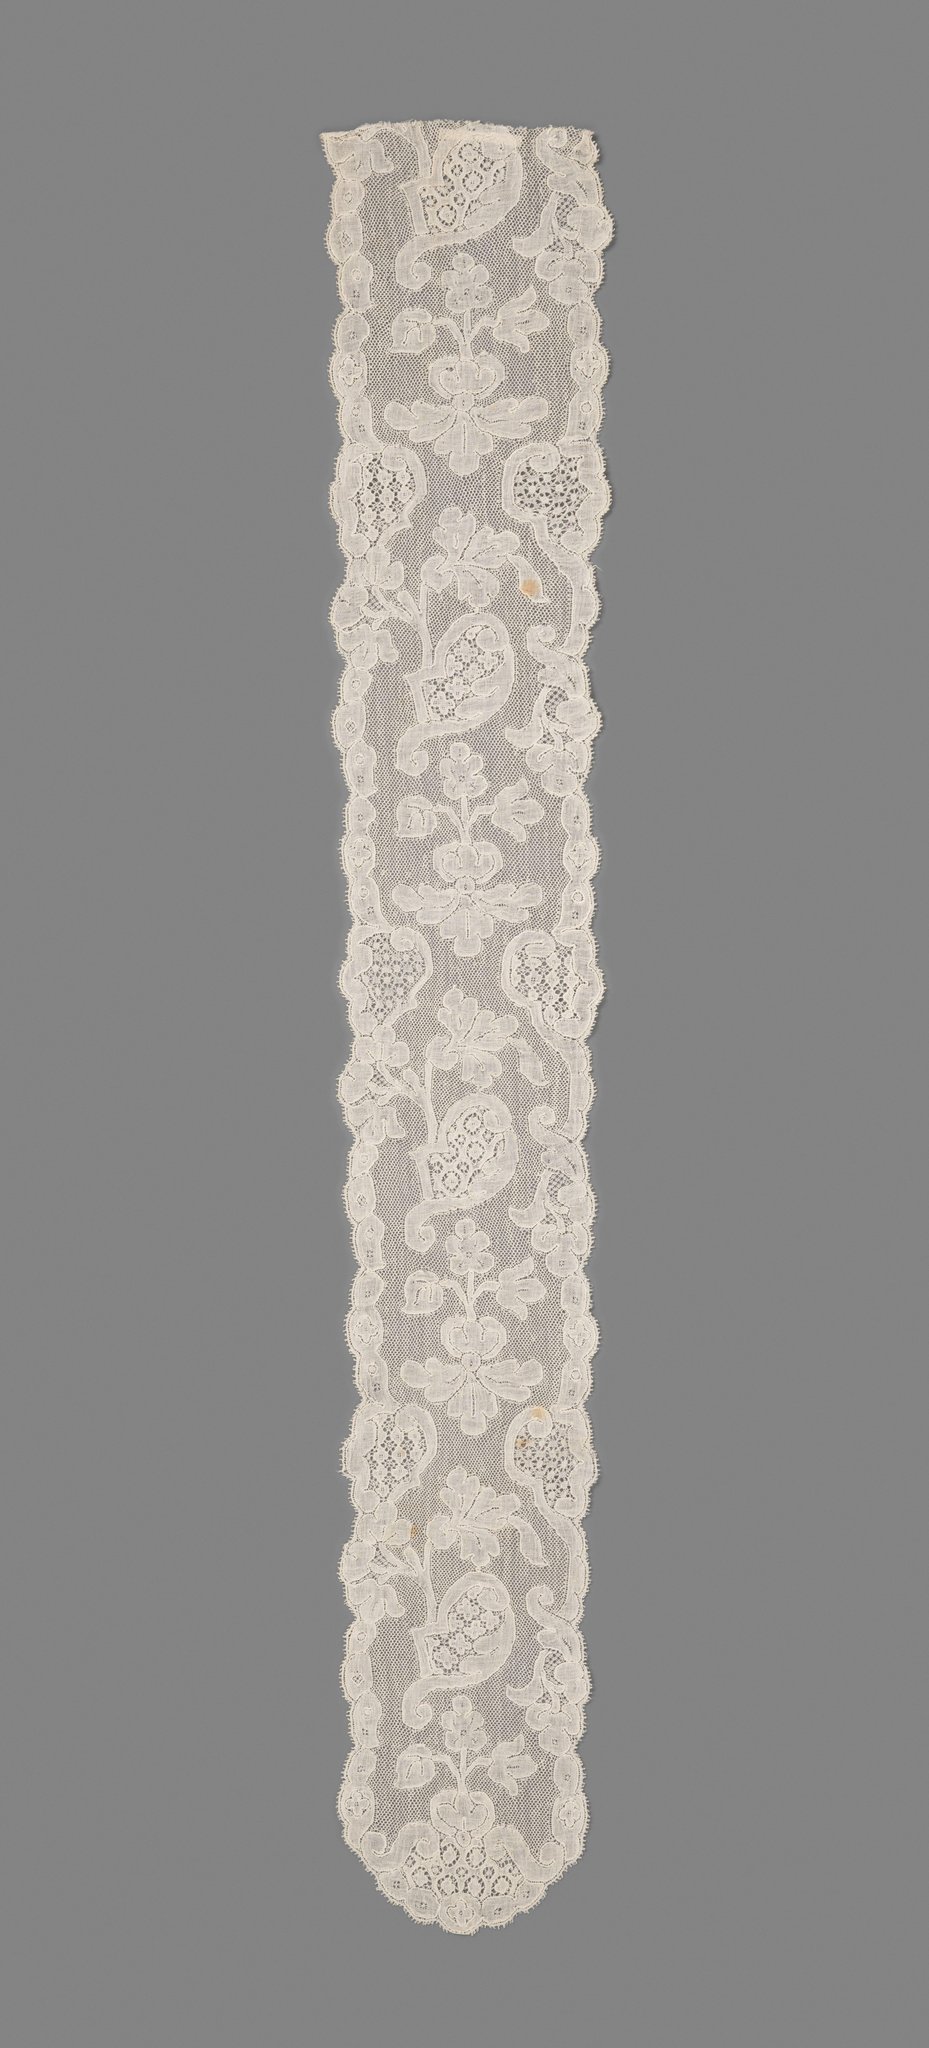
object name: lappet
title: Mutsenslip van kloskant met anjer en rocaille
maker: Anonymous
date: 1750-1760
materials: linen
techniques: lace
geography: mechelen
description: Mutsenslip van naturelkleurige kloskant: Mechelse kant. Eén afgerond uiteinde en het andere uiteinde is recht afgeknipt en niet afgewerkt. Het zich herhalende patroon bestaat uit een anjer die in de lengte-richting van de mutsenslip is geplaatst afgewisseld door een rocaille-motief waaruit een gespleten tak met bladeren ontspringt. Een deel van de bladeren raakt één van de lange zijden. Het patroon langs de lange zijden bestaat verder uit aaneengeschakelde blaadjes en op regelmatige afstand een rocaille-motief. De motieven zijn gemaakt in linnenslag met spaarzaam toegepaste uitsparingen en voorzien van dikkere contourdraden. De motieven zijn met elkaar verbonden door een traliegrond, een Mechelse grond. In de rocailles en tussen sommige bladeren zijn siergronden toegepast. Op het afgeknipte uiteinde na zijn de randen van de mutsenslip afgewerkt met picots.